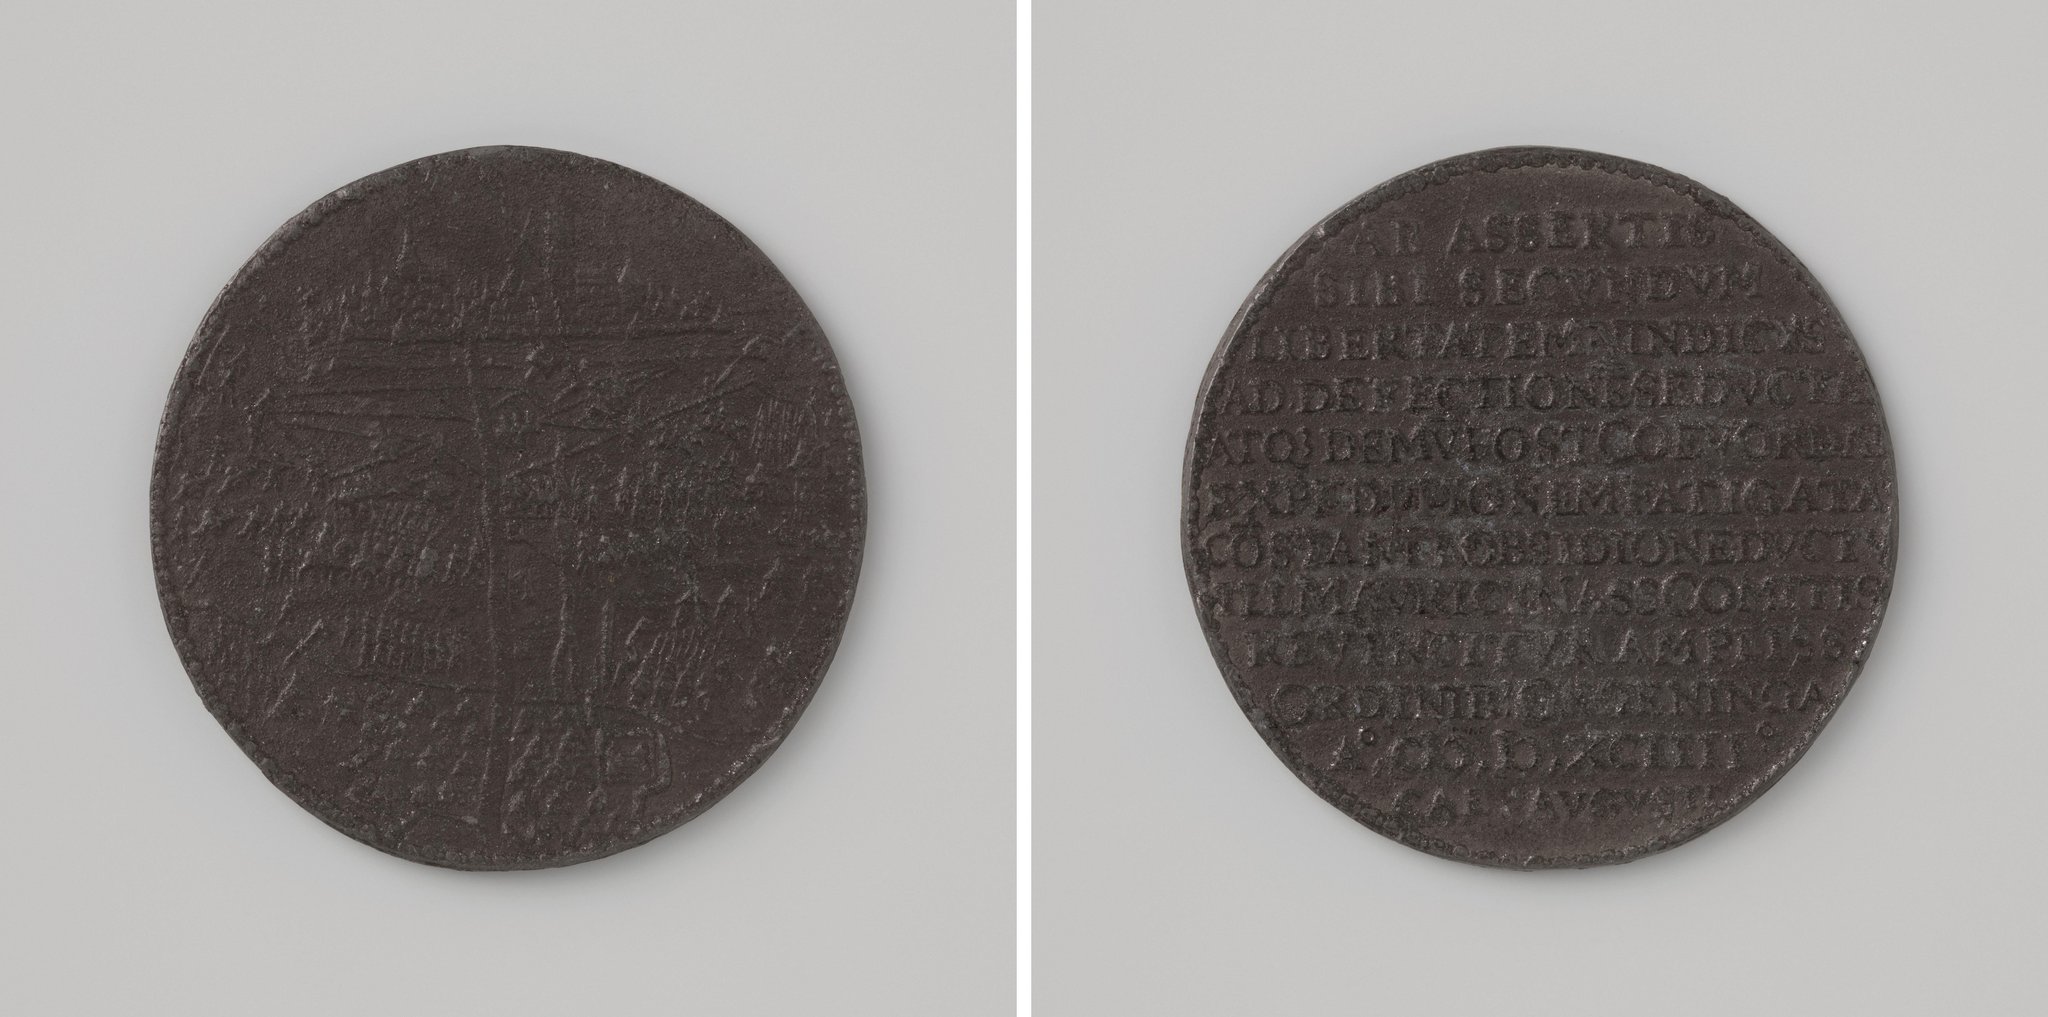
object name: history medal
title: Ontzet van Koevorden en inname van Groningen door Prins Maurits 1594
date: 1594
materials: tin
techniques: casting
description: Tinnen penning, op de voorzijde aanzicht en plattegrond van Groningen met militairen, op de keerzijde twaalf regels tekst